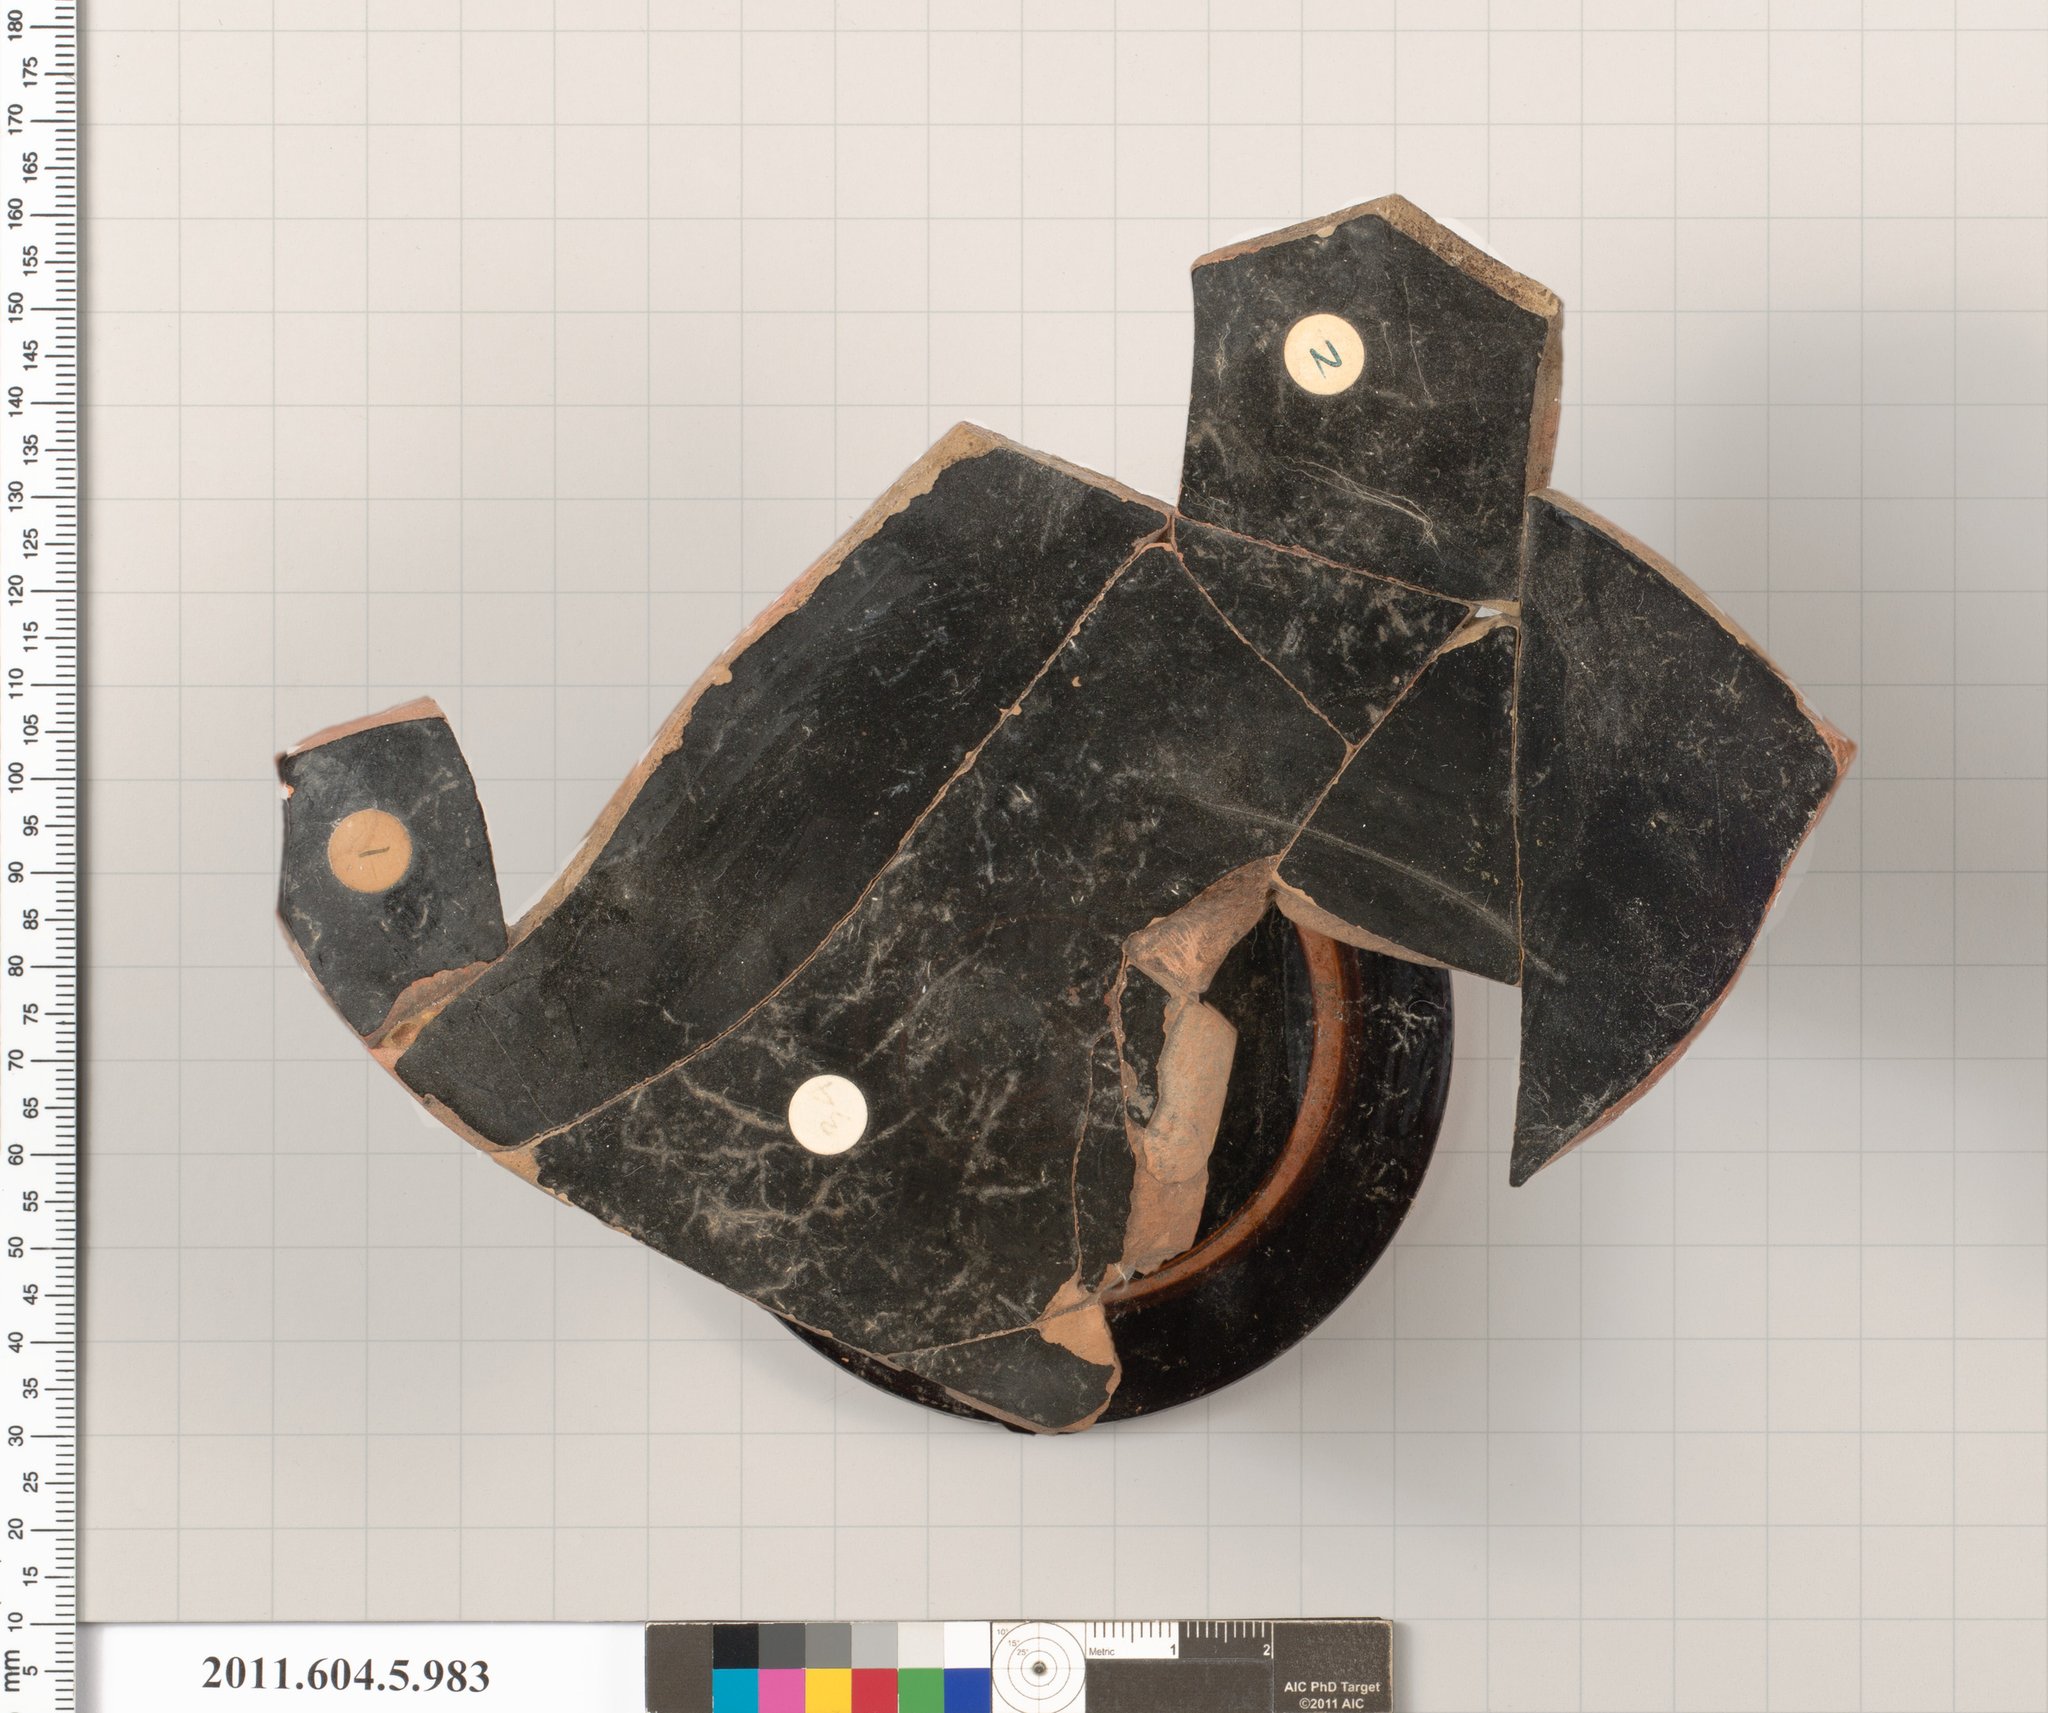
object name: kylix fragment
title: Terracotta fragment of a kylix (drinking cup)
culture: greek, attic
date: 600-401 BCE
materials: terracotta